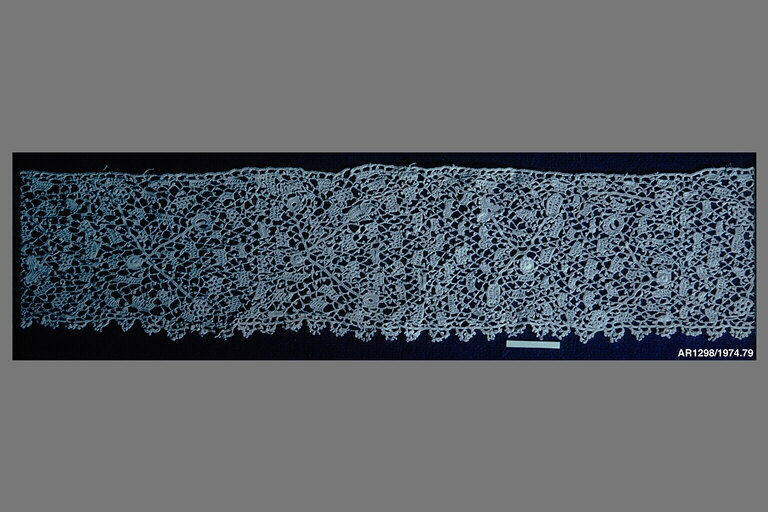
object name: border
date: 1801-1900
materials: linen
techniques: crochet